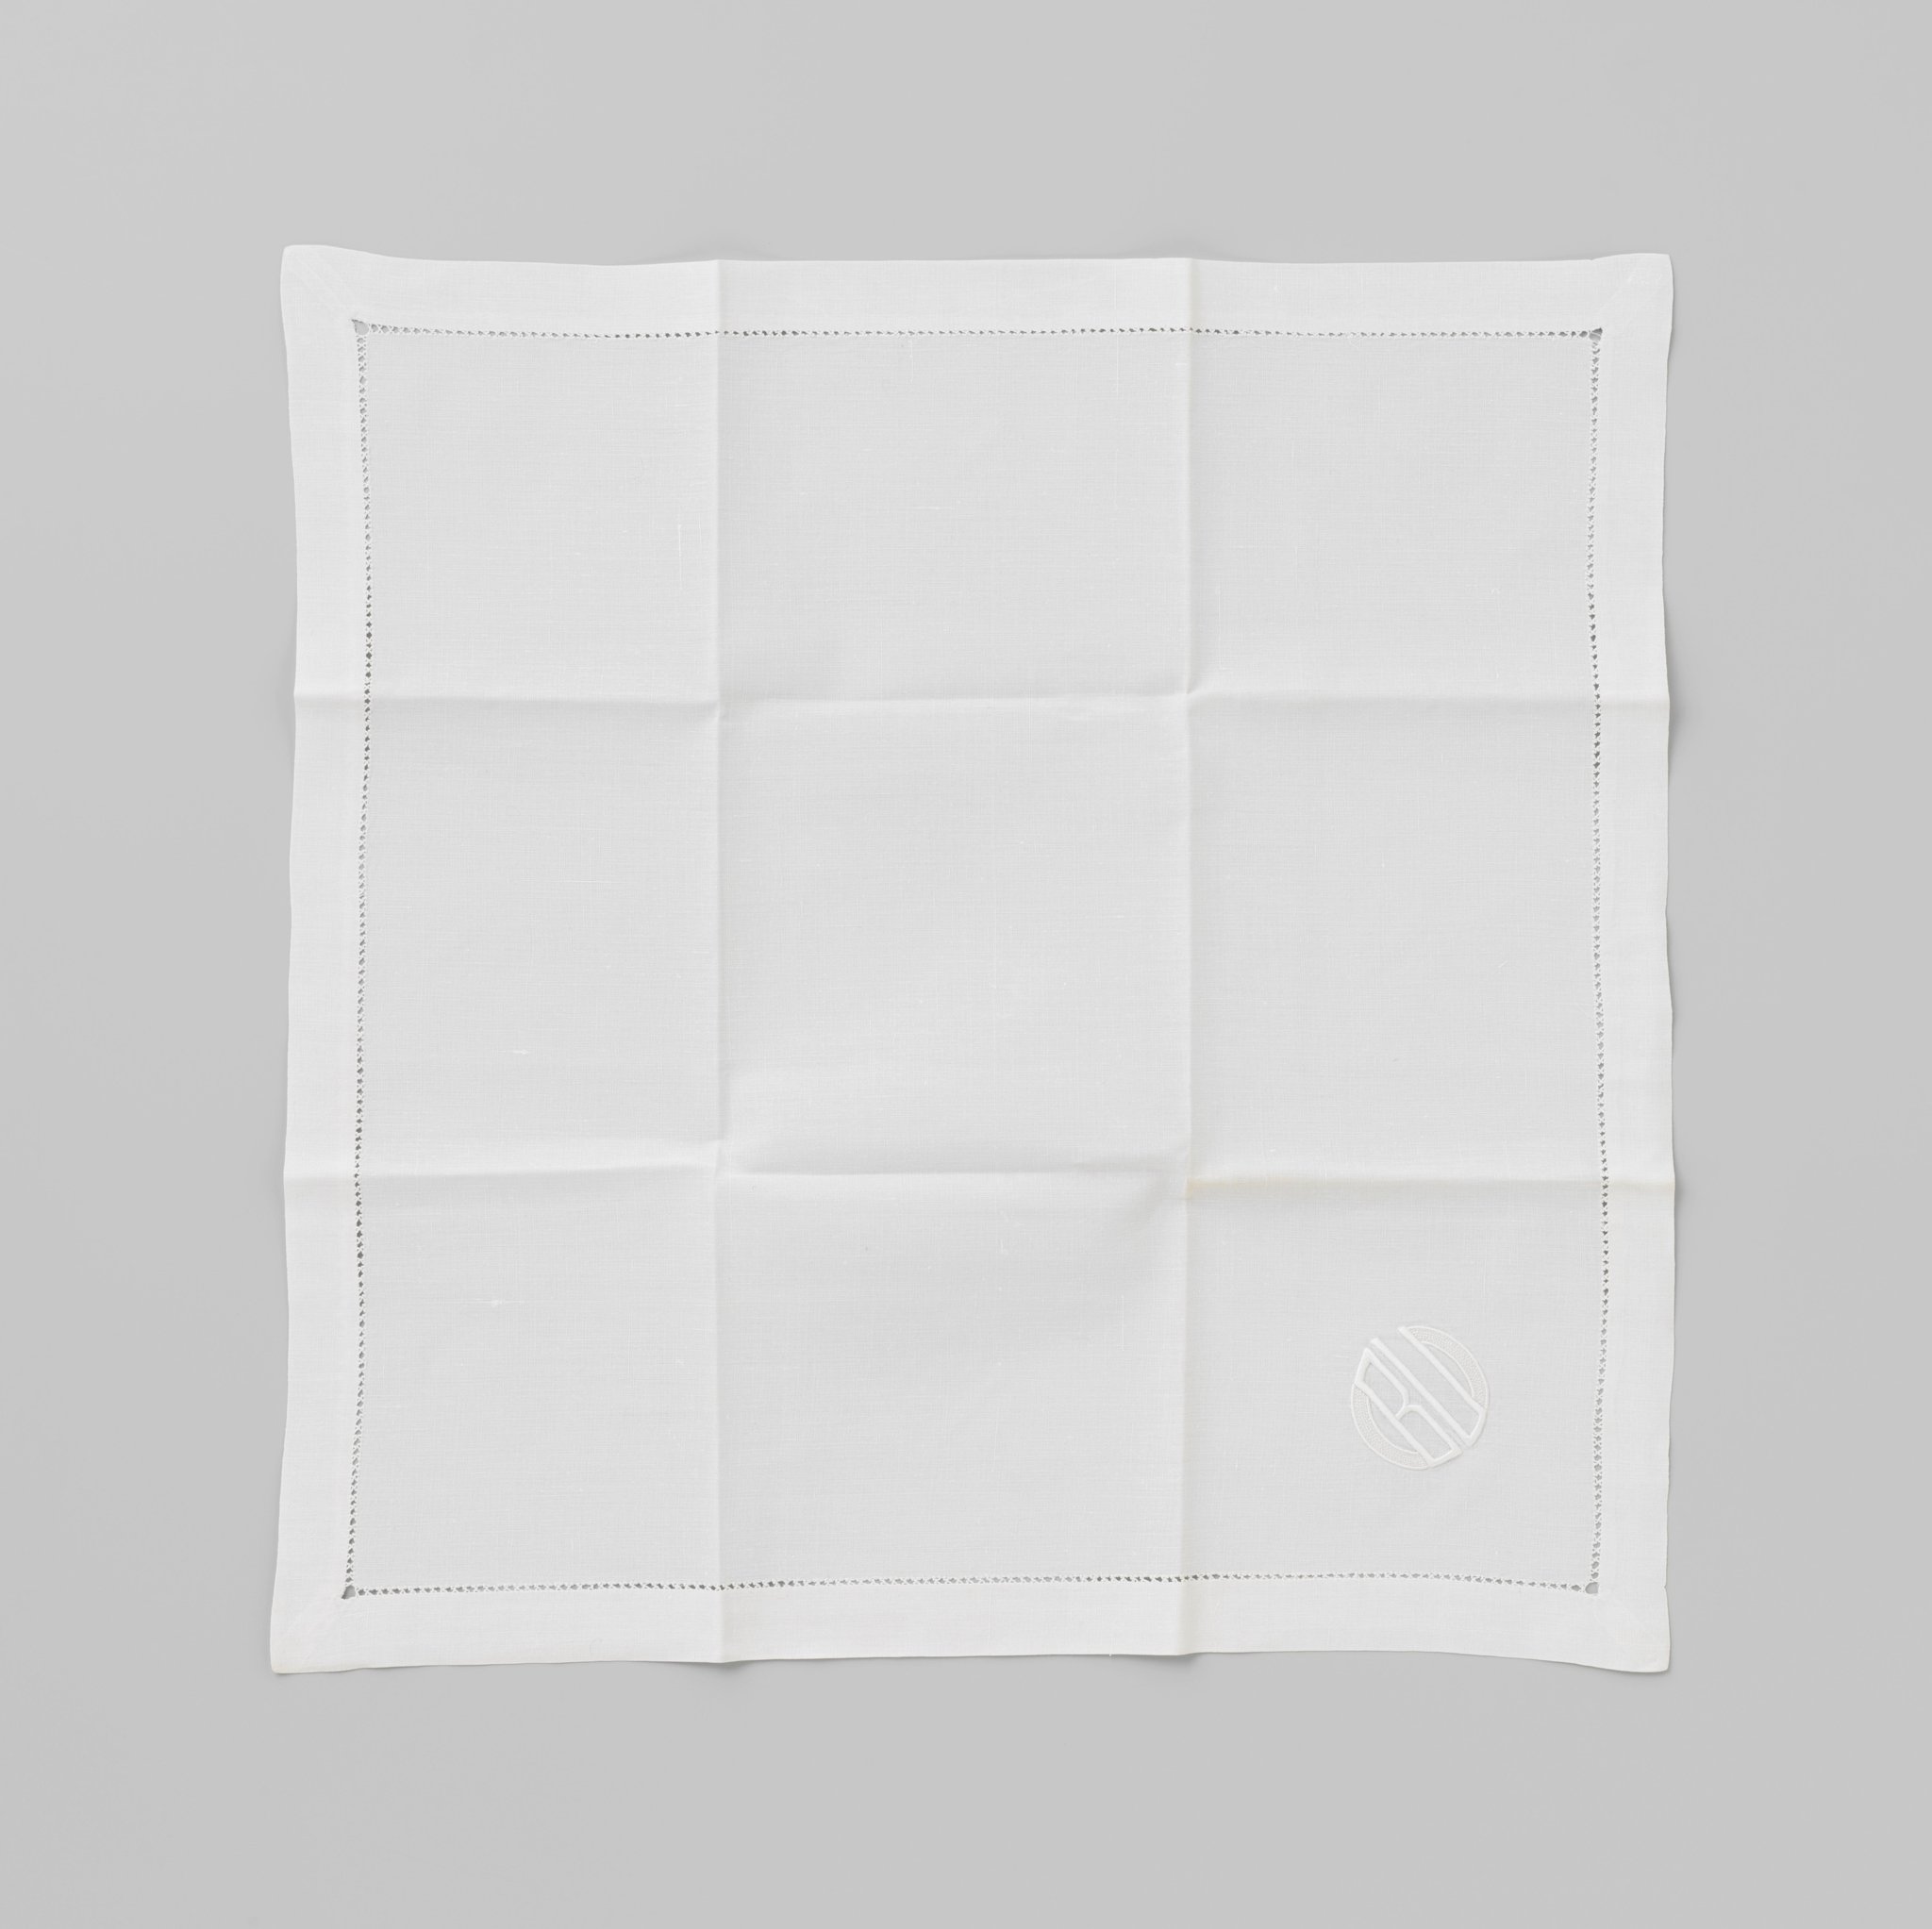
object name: napkin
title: Servet van linnen met de geborduurde initialen BU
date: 1935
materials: linen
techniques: embroidered, weave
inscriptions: initials: ‘BU’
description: Servet van linnen in platbinding, met opengewerkte zomen en de geborduurde initialen BU (Brusse-Urtebise).